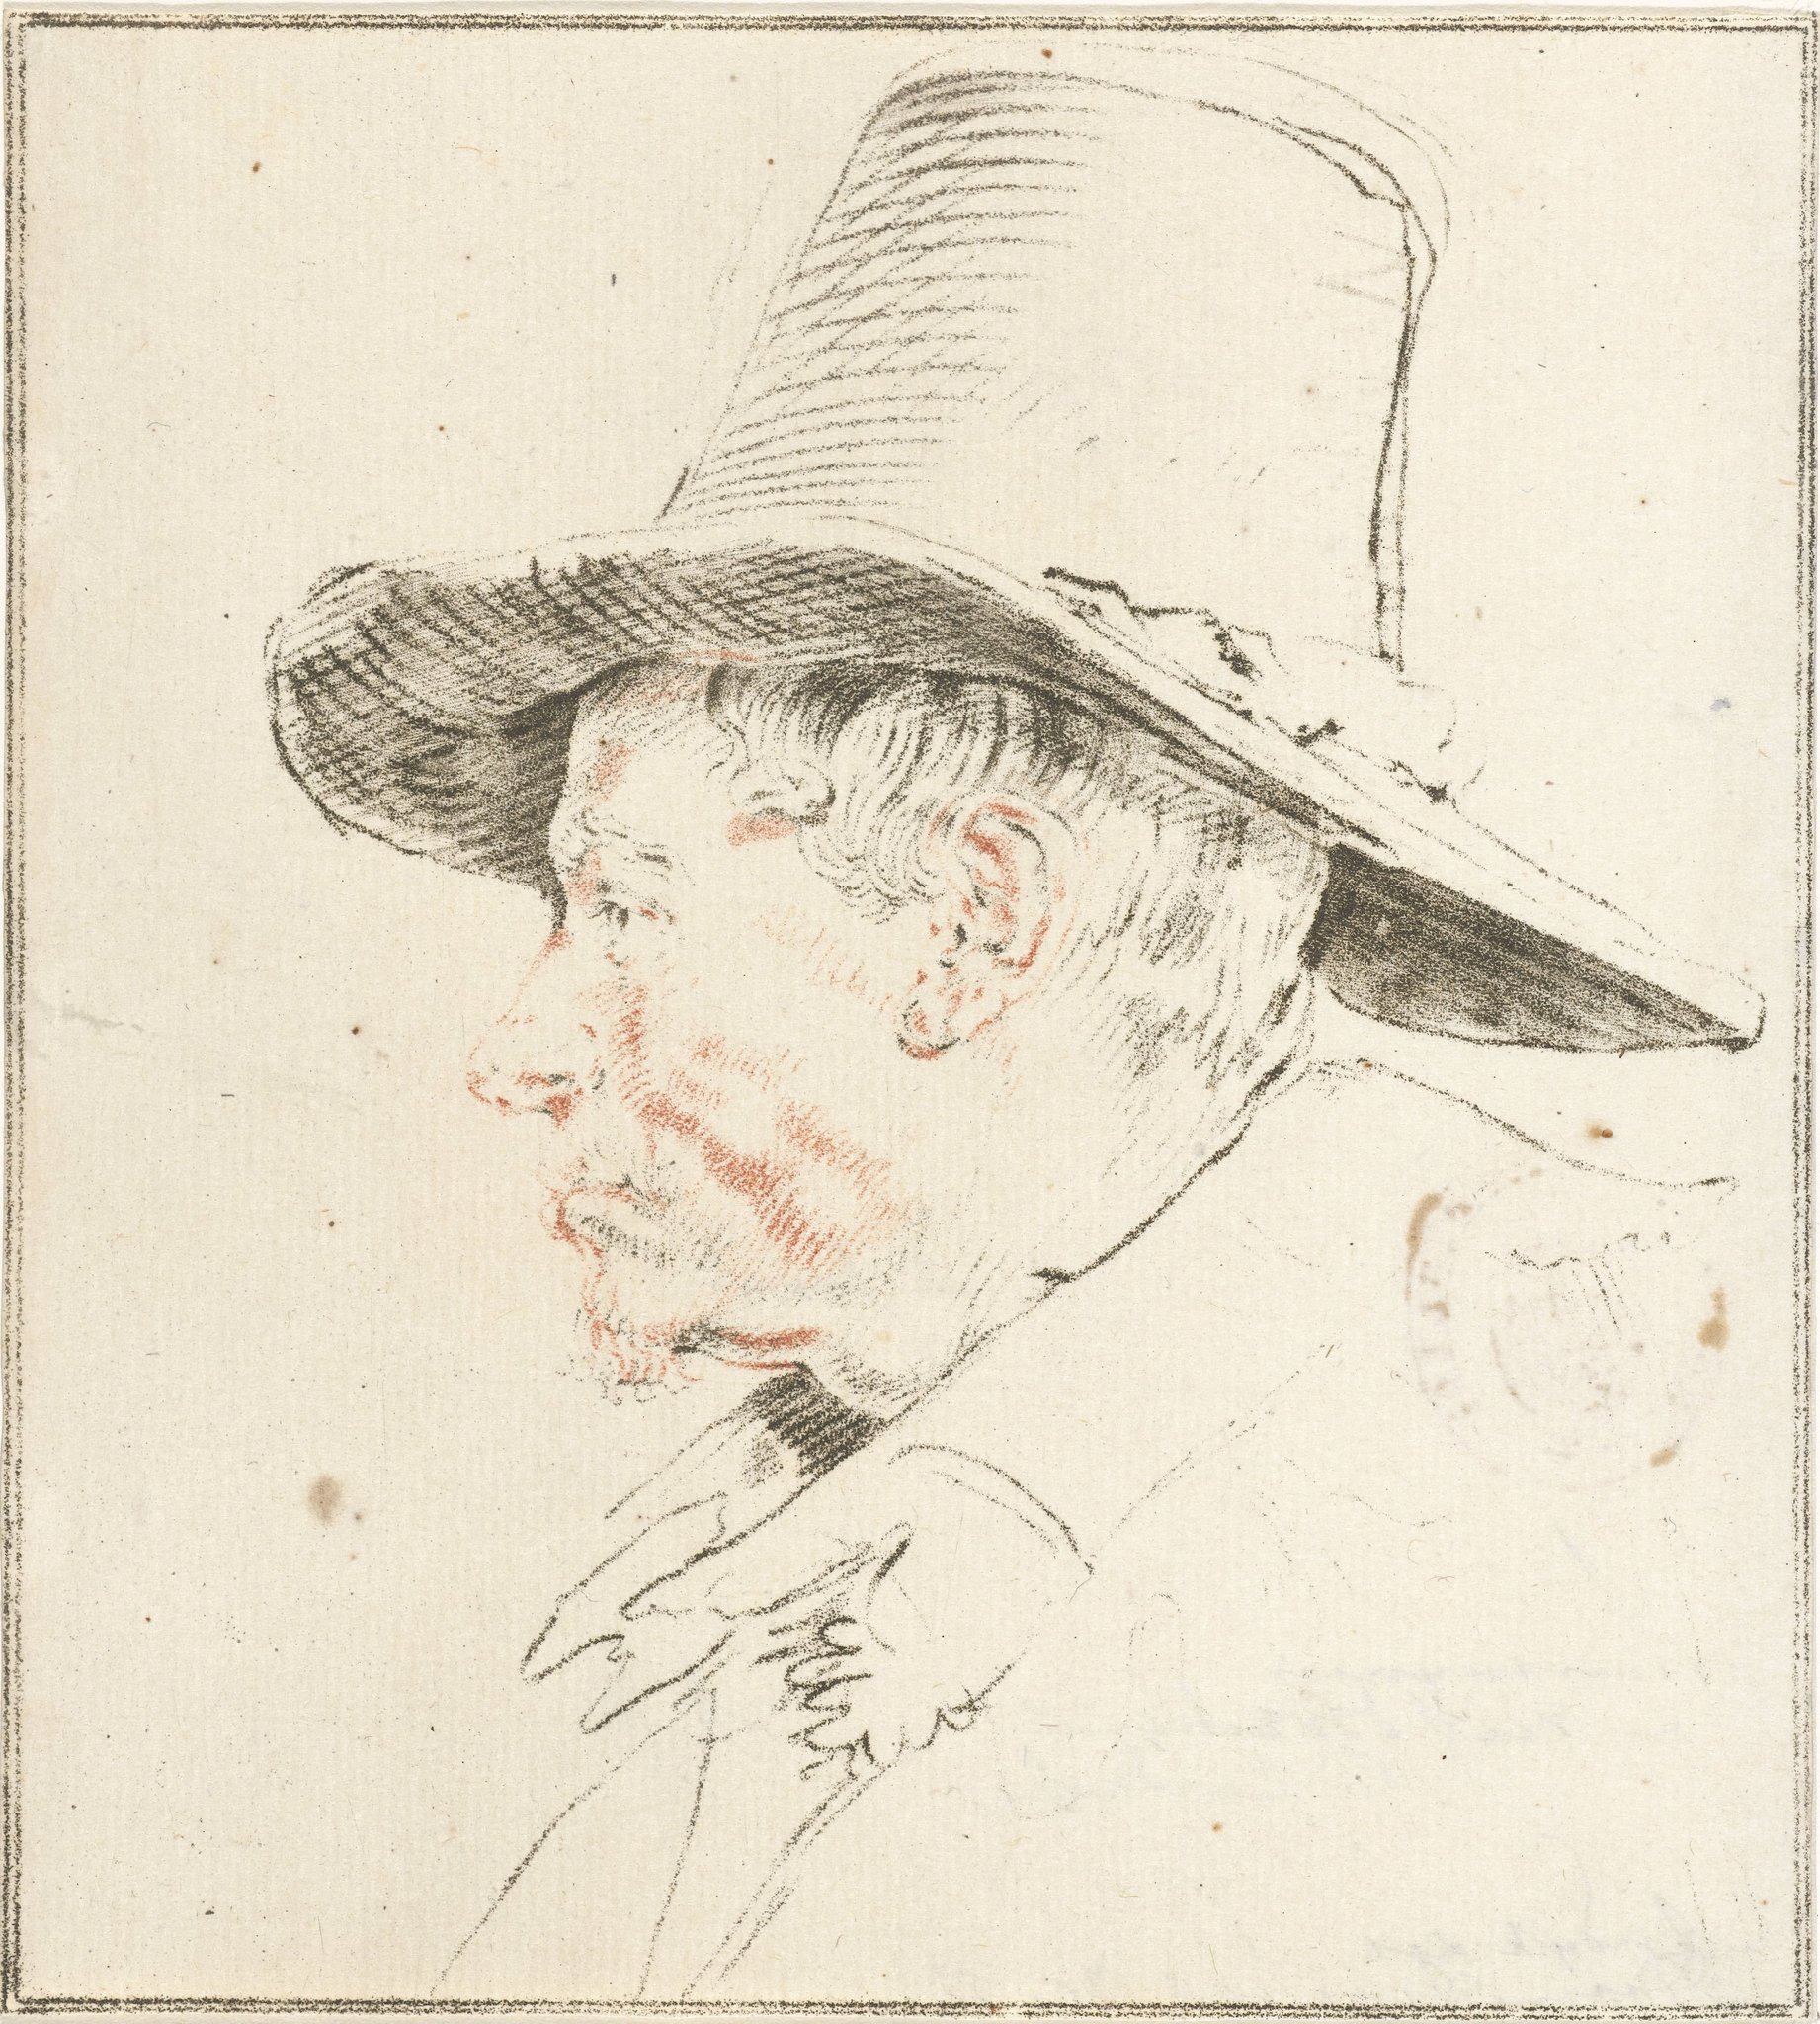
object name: print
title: Portret van een onbekende man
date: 1766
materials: paper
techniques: printing, printmaking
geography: amsterdam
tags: adult man, head-gear: hat (+ men's clothes)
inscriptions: collector's mark: Lugt 240, inscription: ‘2 proef / Aan mijnen neef [...] A v Dijk del CPloos v Amstel f’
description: Portret van een man met een hoed op zijn hoofd.